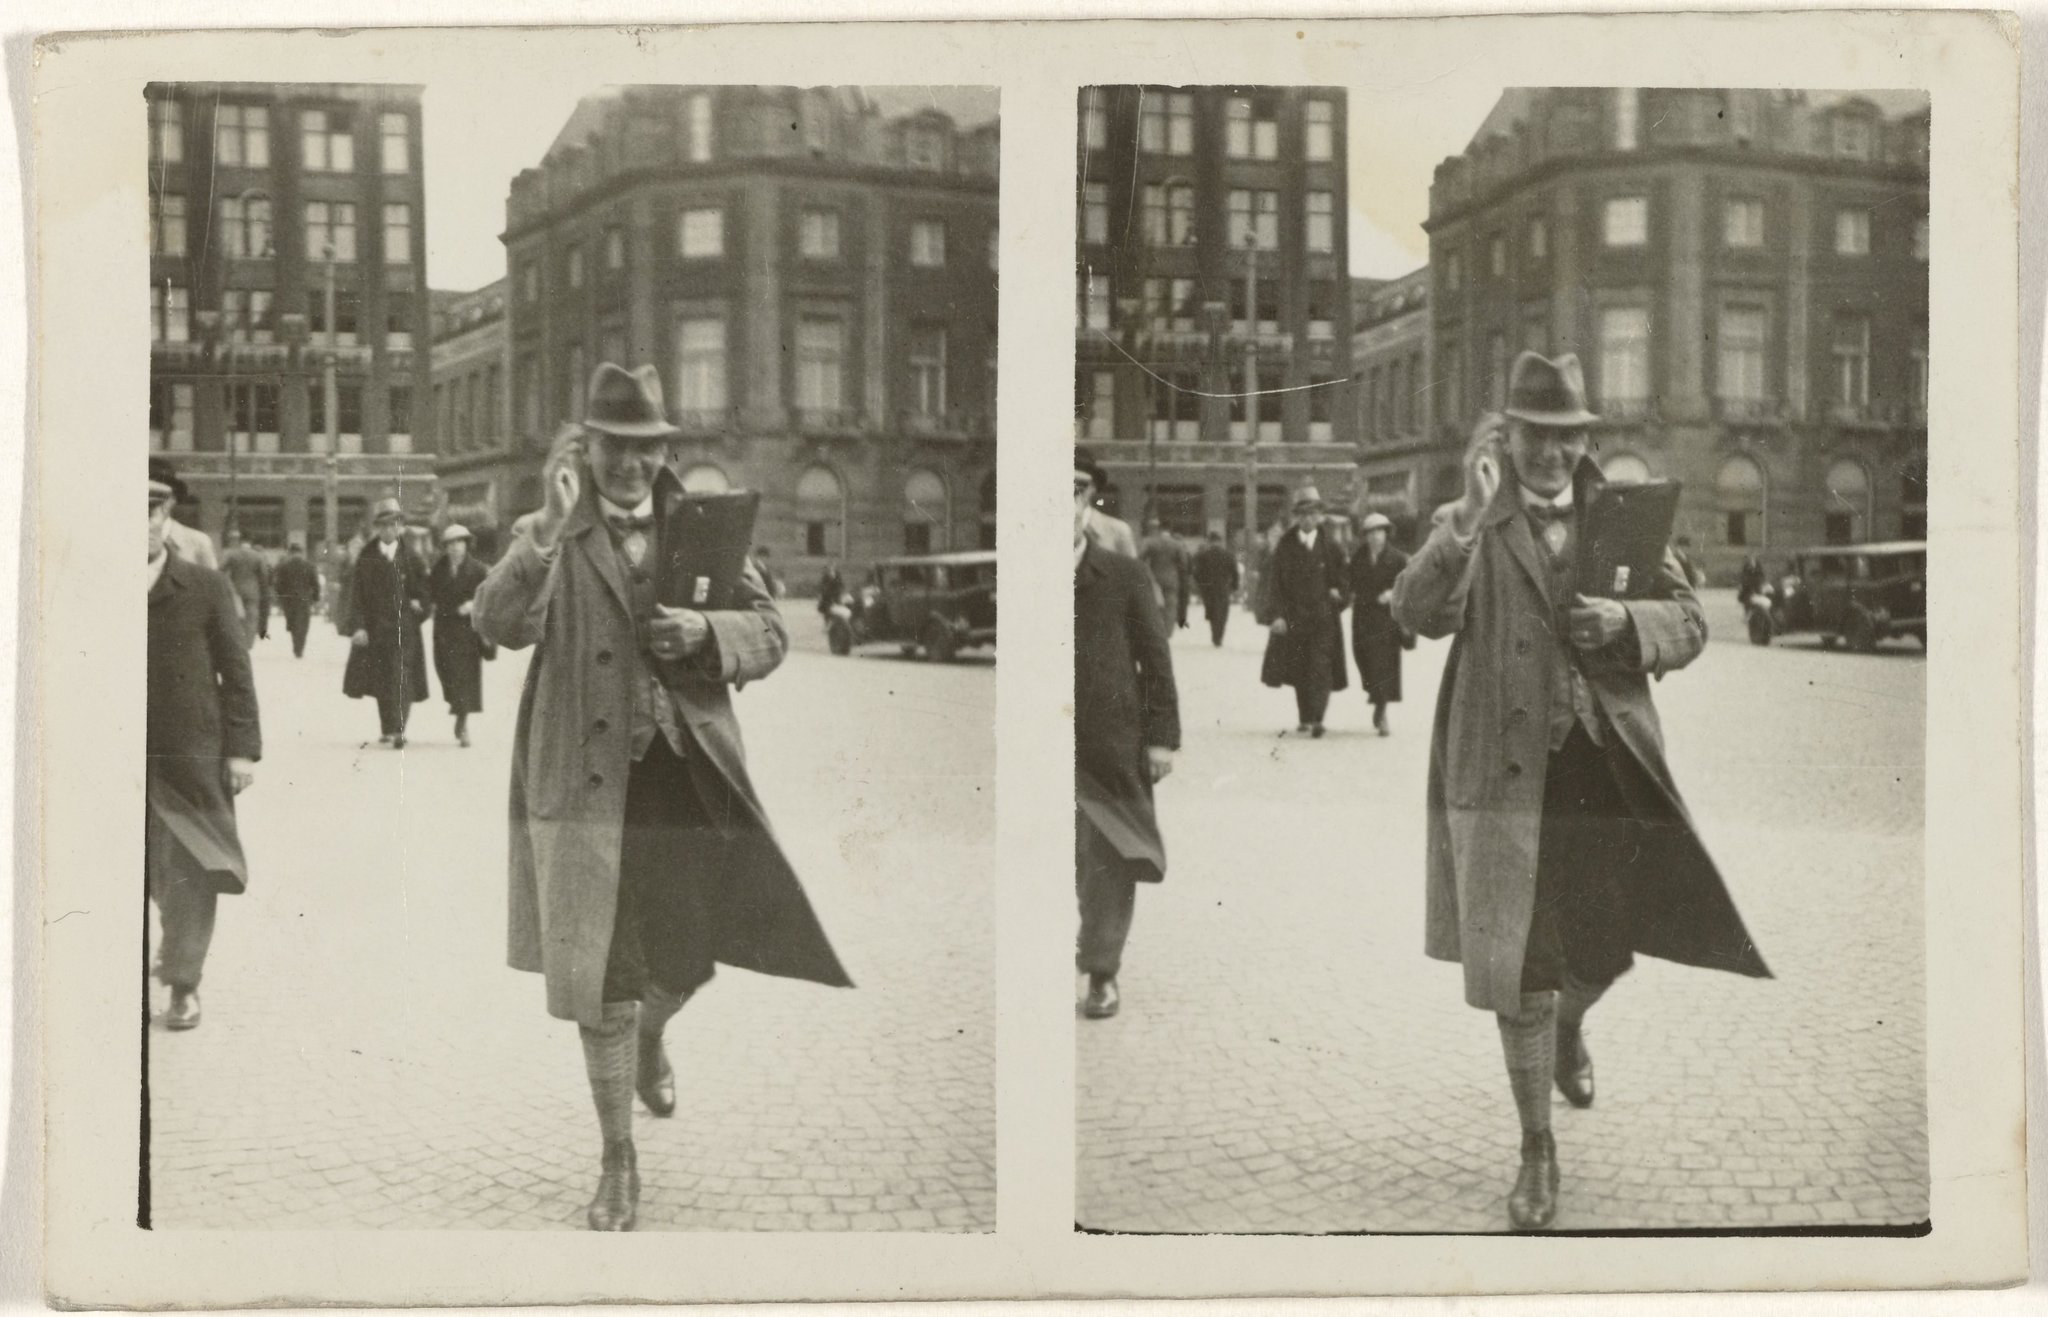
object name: stereograph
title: Portret van een onbekende groetende man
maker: Anonymous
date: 1906-1936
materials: photographic support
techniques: gelatin silver print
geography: amsterdam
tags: adult man, street, historical persons not known by name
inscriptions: stamp: ‘"QUICK"/ Foto's Filme/ Westermarkt 18/ AMSTERDAM’, date: ‘15 JUNI 1936’, inscription: ‘POST CARD/ CORRESPONDENCE ADRESS’, inscription: ‘Juni 1936’, inscription: ‘030’